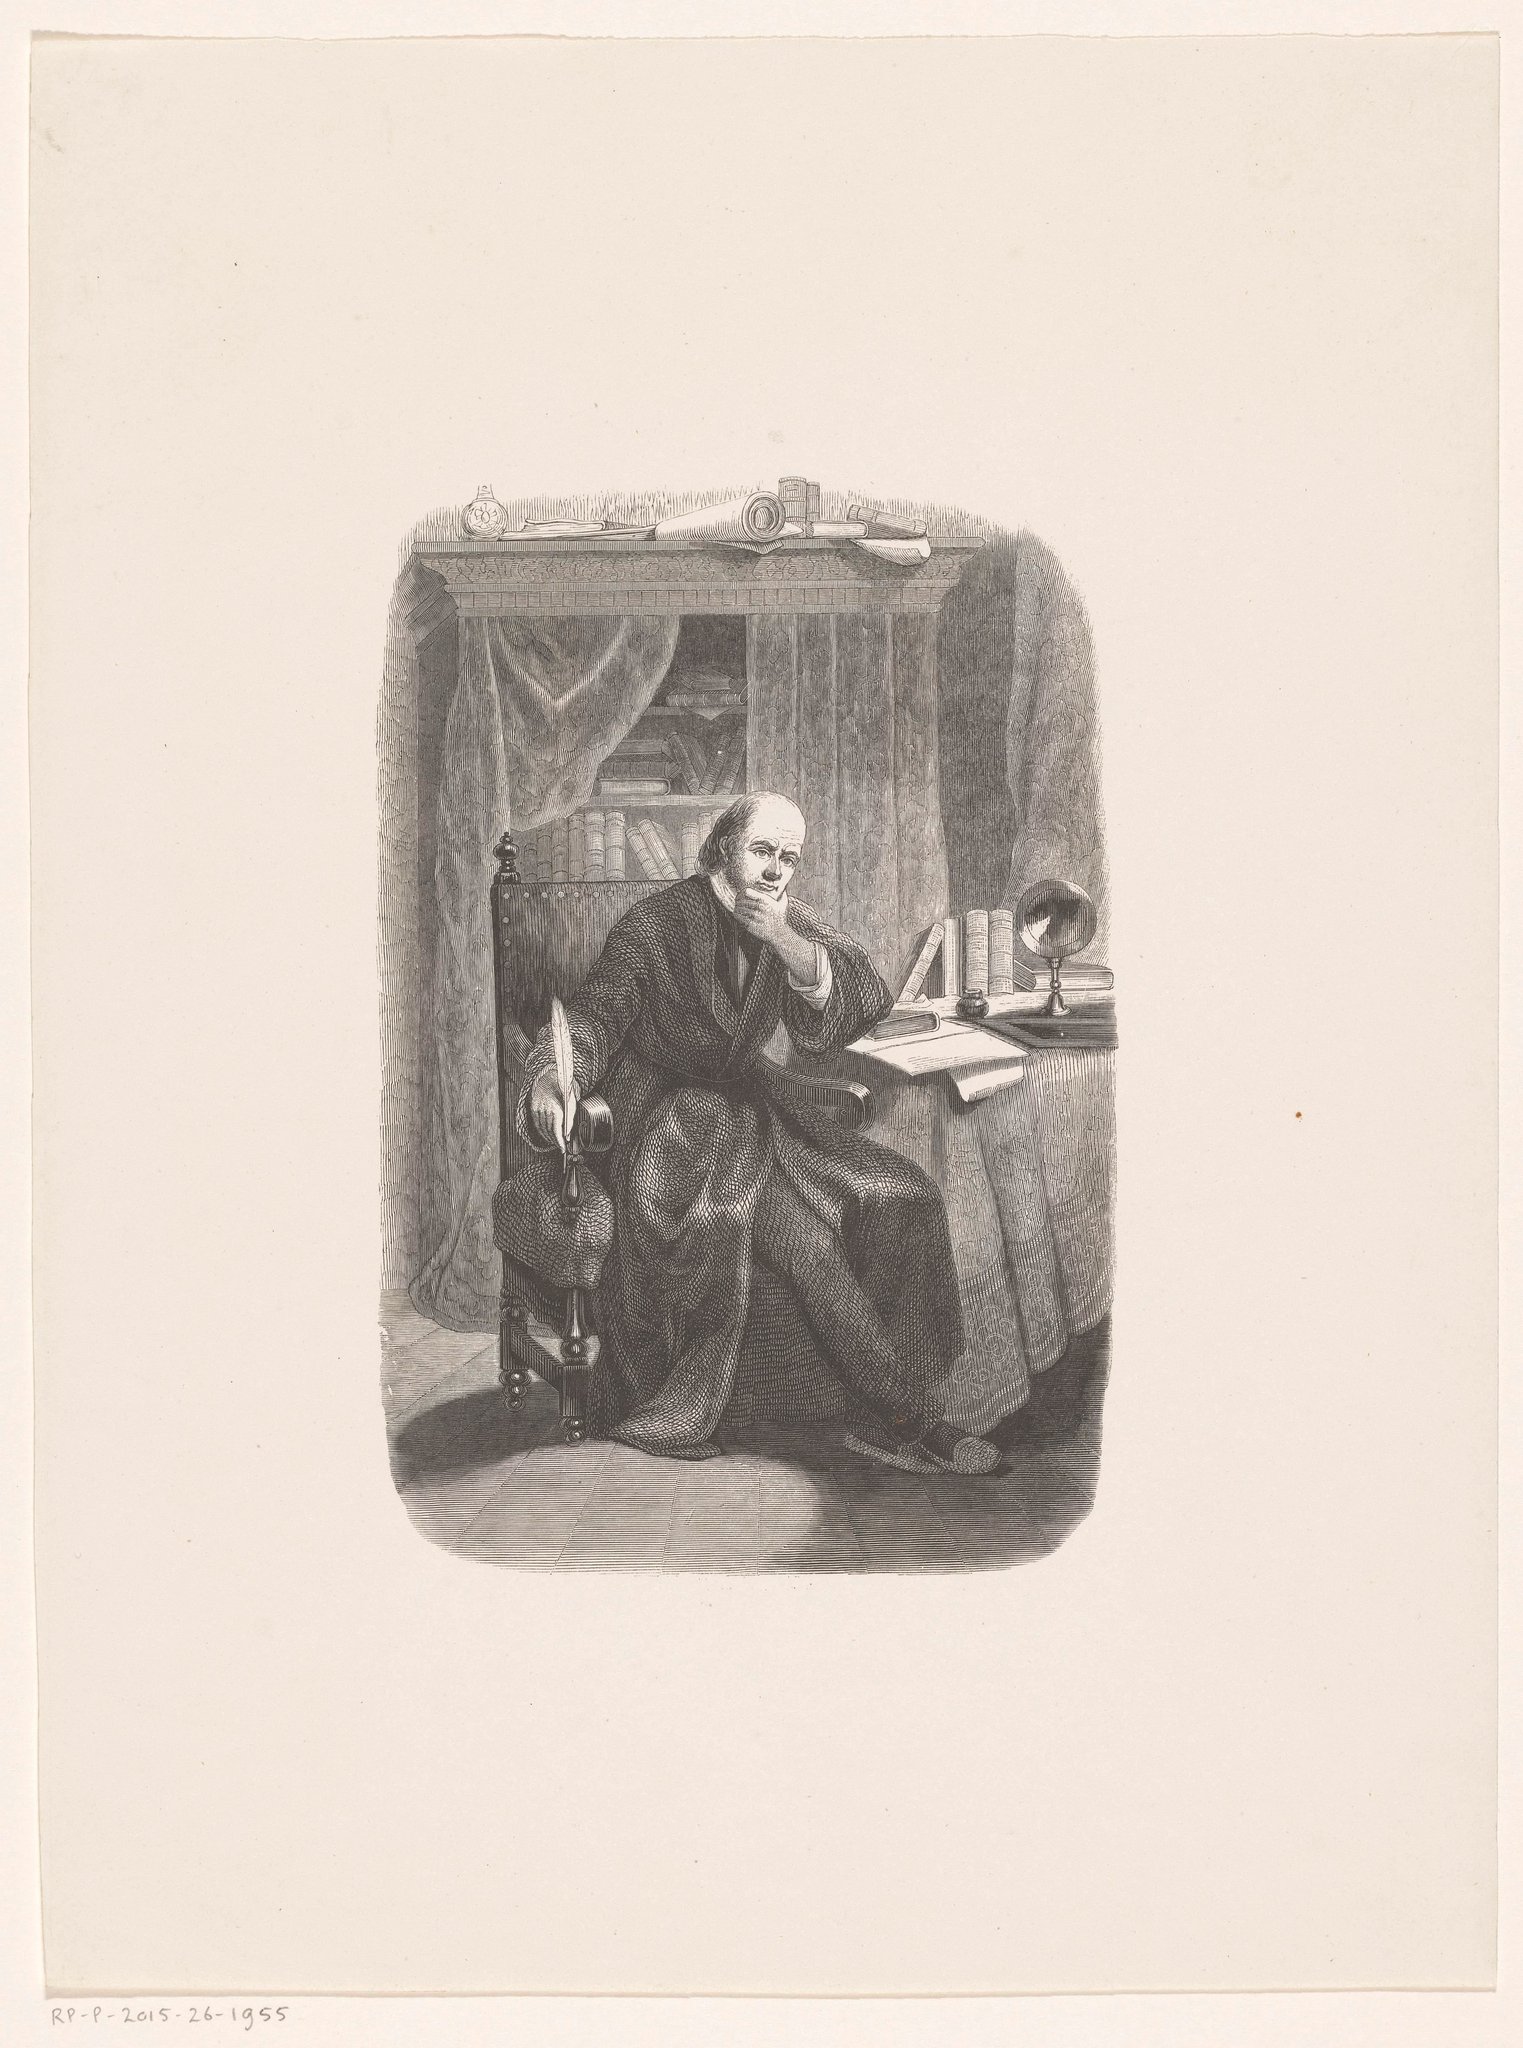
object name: book illustration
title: Portret van Johannes Immerzeel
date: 1842-1843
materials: paper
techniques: engraving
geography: amsterdam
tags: publisher, johannes immerzeel, quill, ink-well, lens, table, book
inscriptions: collector's mark: Lugt 4780, collector's mark: Lugt 2228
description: Prent uit: Immerzeel, Johannes. De levens en werken der Hollandsche en Vlaamsche kunstschilders, beeldhouwers, graveurs en bouwmeesters: van het begin der vijftiende eeuw tot heden. Amsterdam: J.C. van Kesteren, 1842-1843.